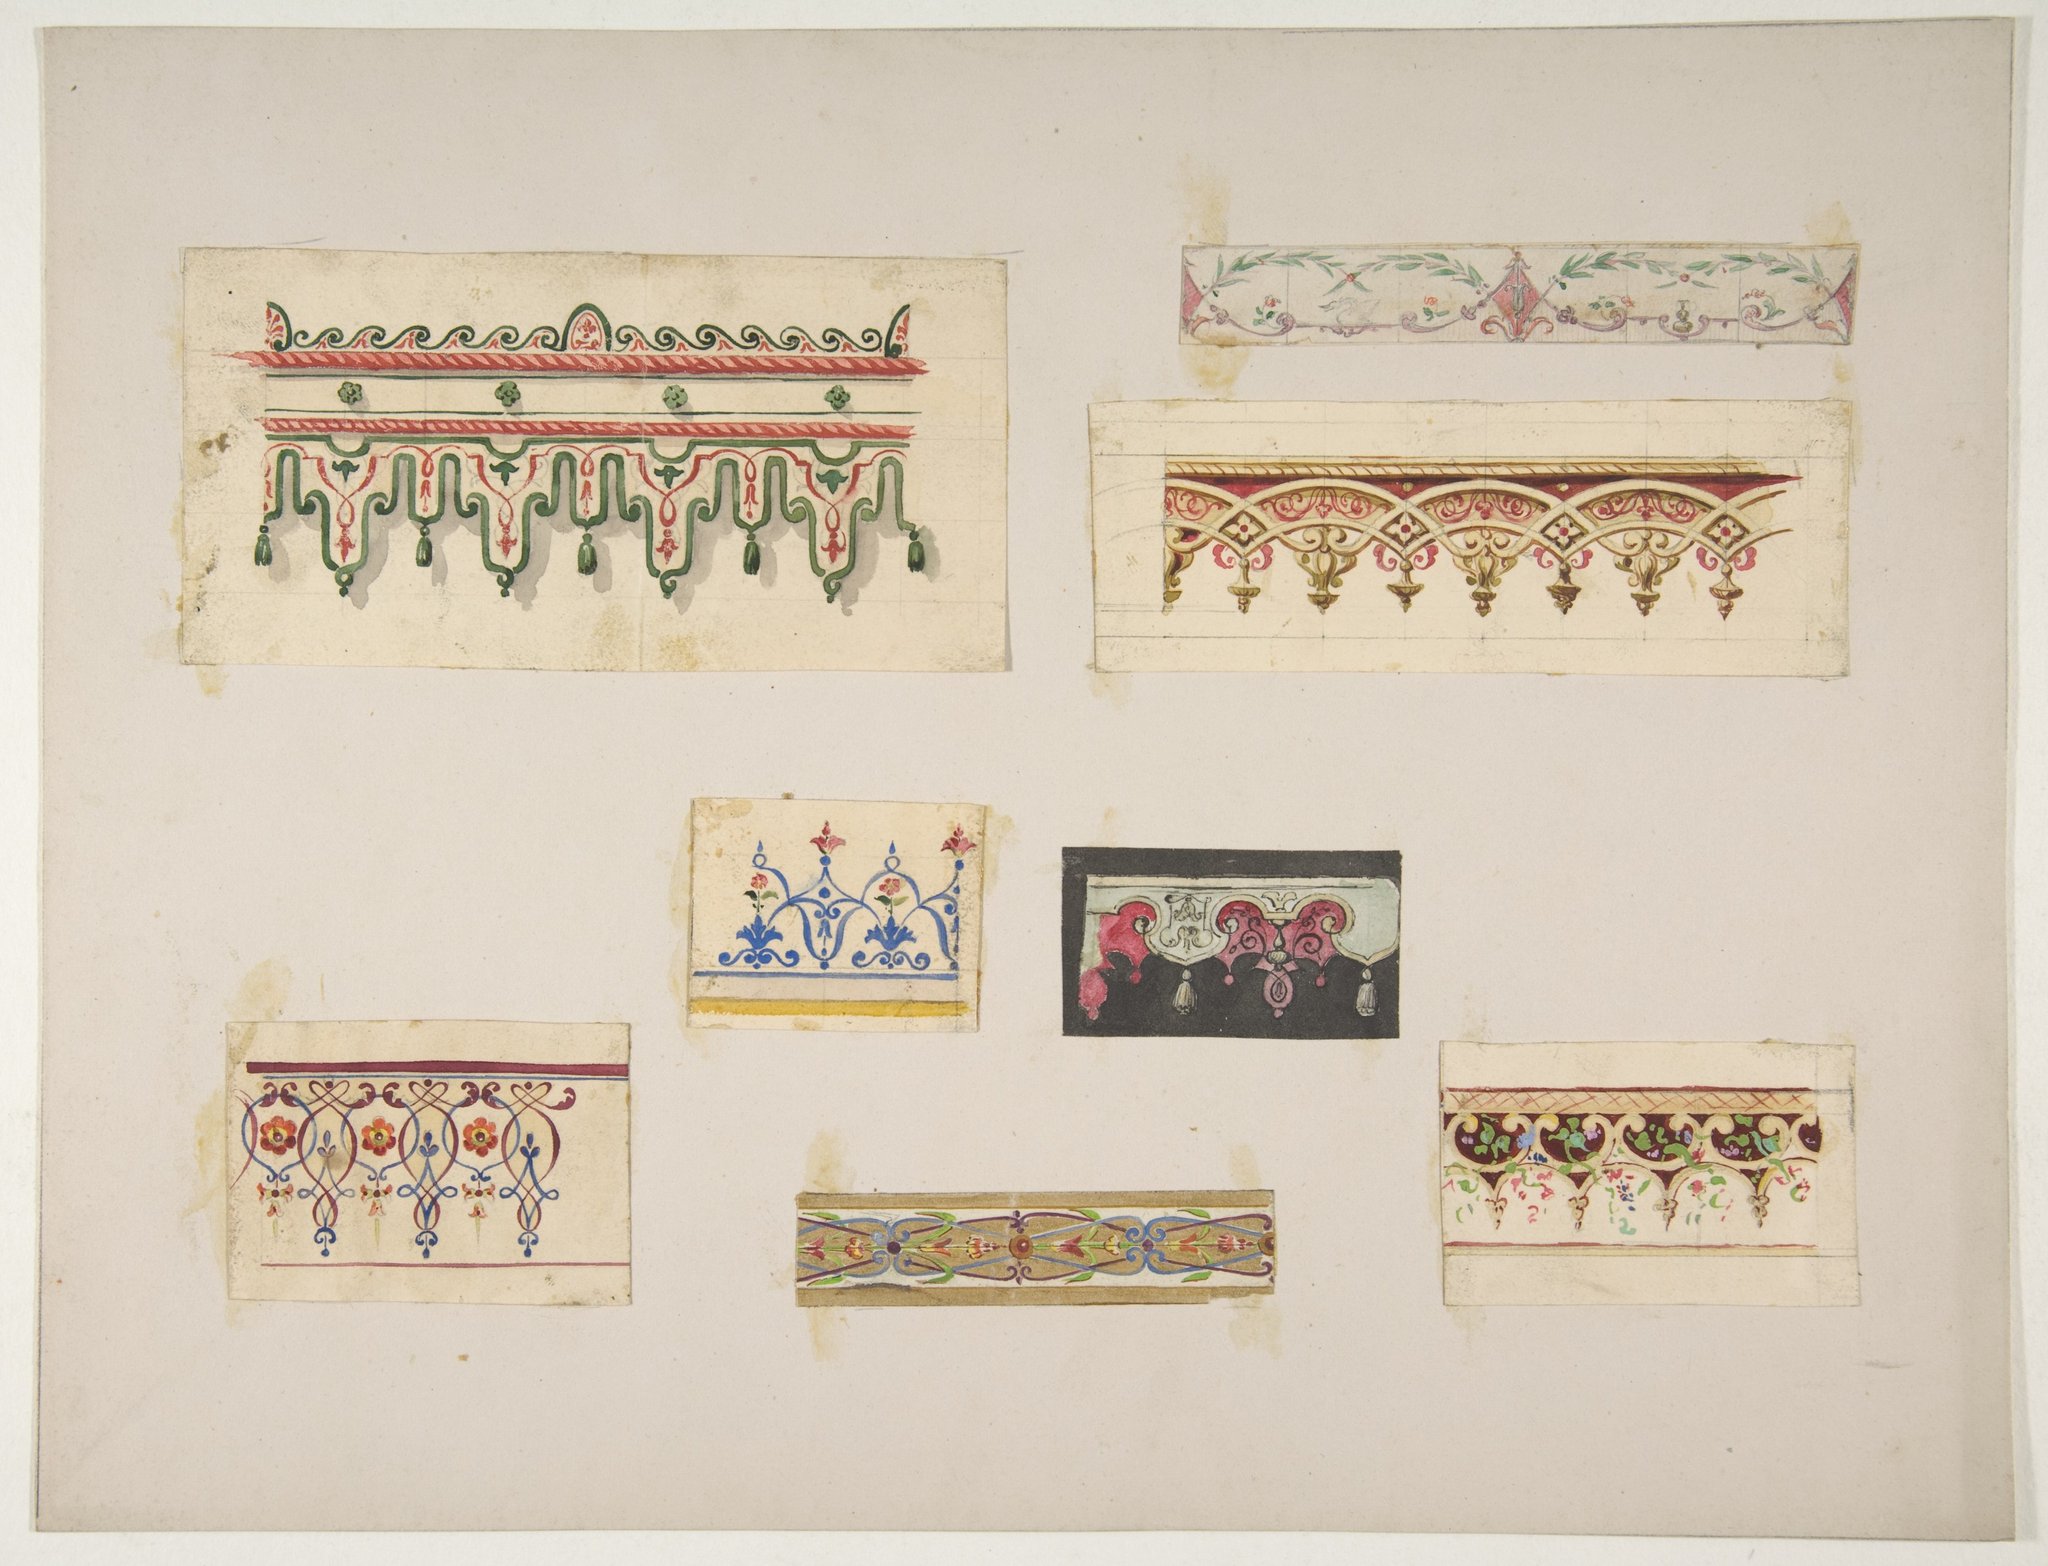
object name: drawing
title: Eight designs for decorative borders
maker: jules-edmond-charles lachaise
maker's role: artist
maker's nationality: french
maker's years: 1897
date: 1830-1897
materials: gold paint, graphite, paper, watercolor